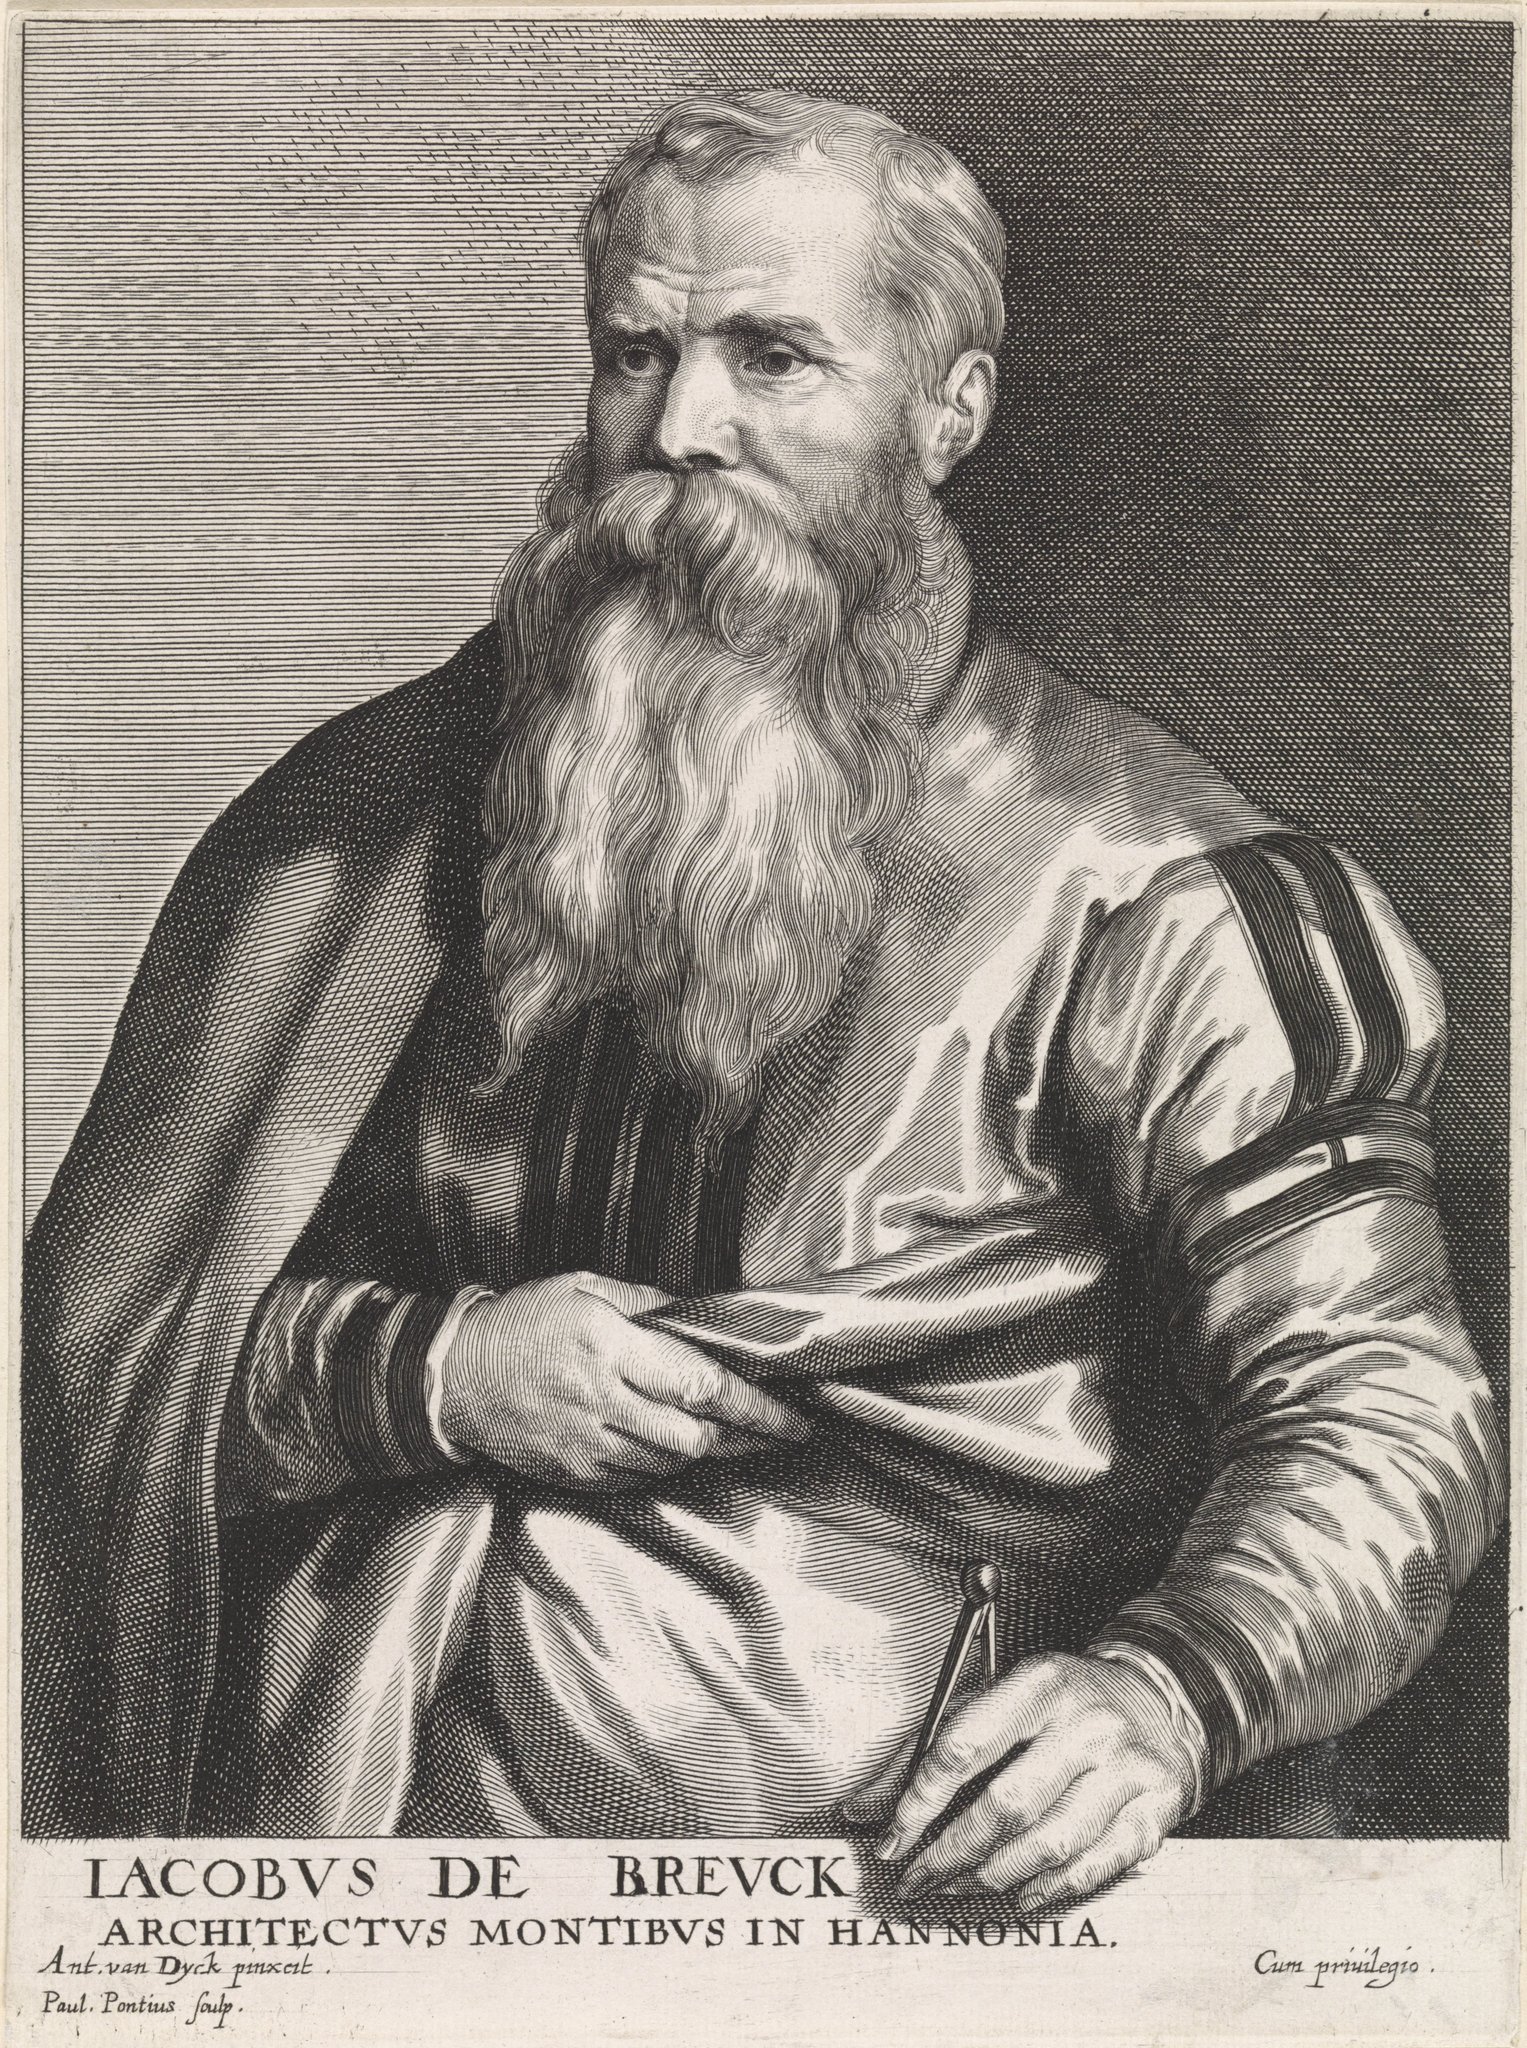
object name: print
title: Portret van de architect Jacob de Breuck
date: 1616-1657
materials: paper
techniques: engraving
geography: antwerp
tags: compasses, portrait, self-portrait of architect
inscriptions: collector's mark: Lugt 240